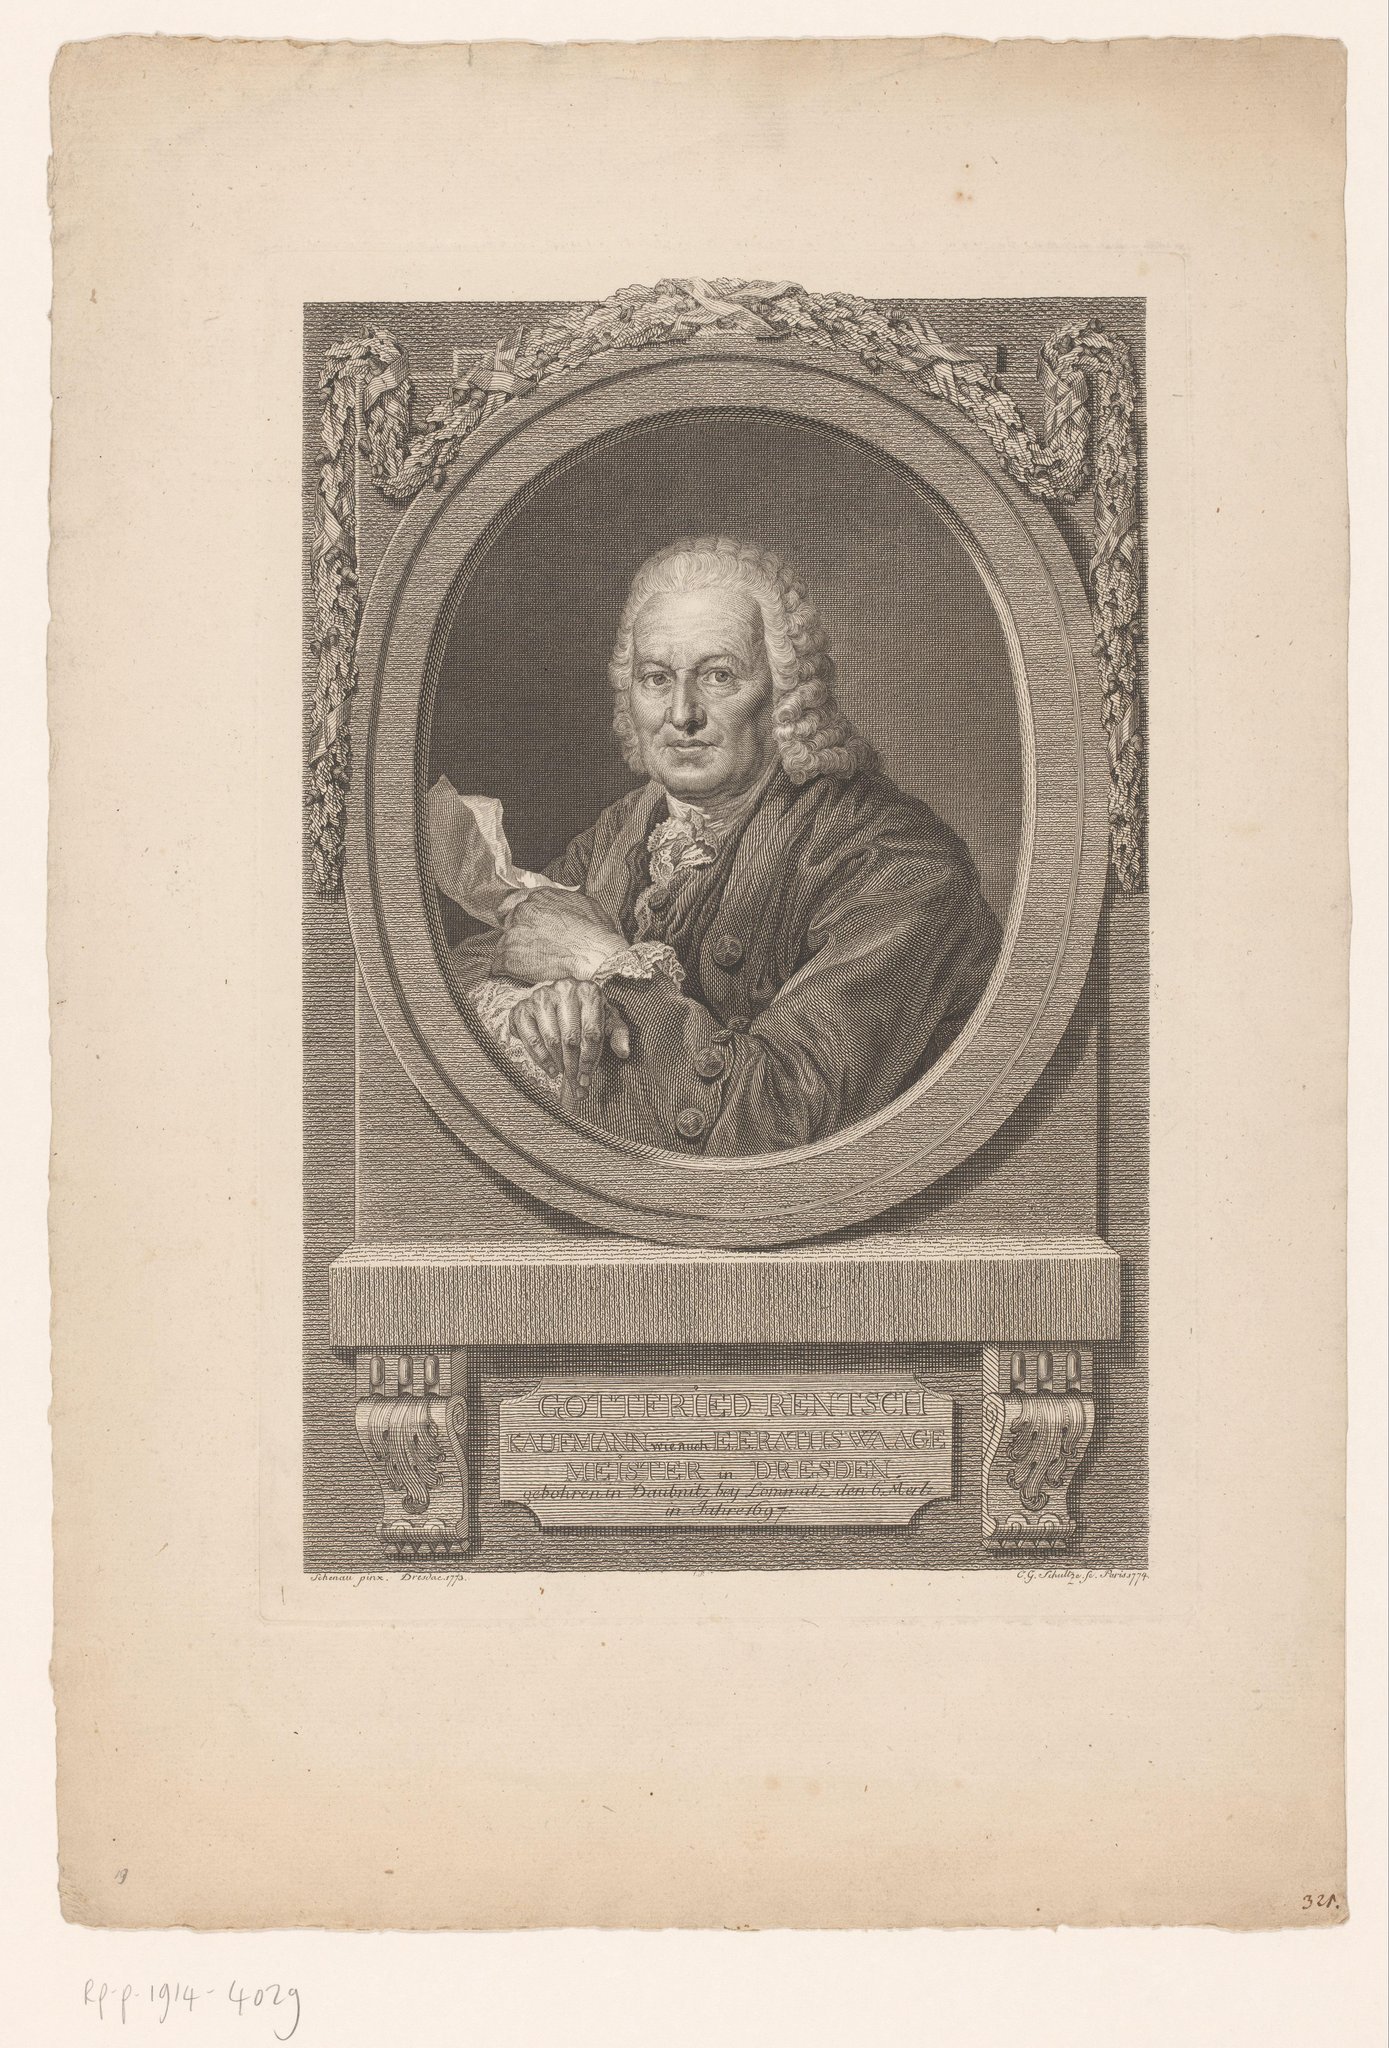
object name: print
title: Portret van Gottfried Rentsch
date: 1759-1819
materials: paper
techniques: etching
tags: historical persons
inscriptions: collector's mark: Lugt 2228